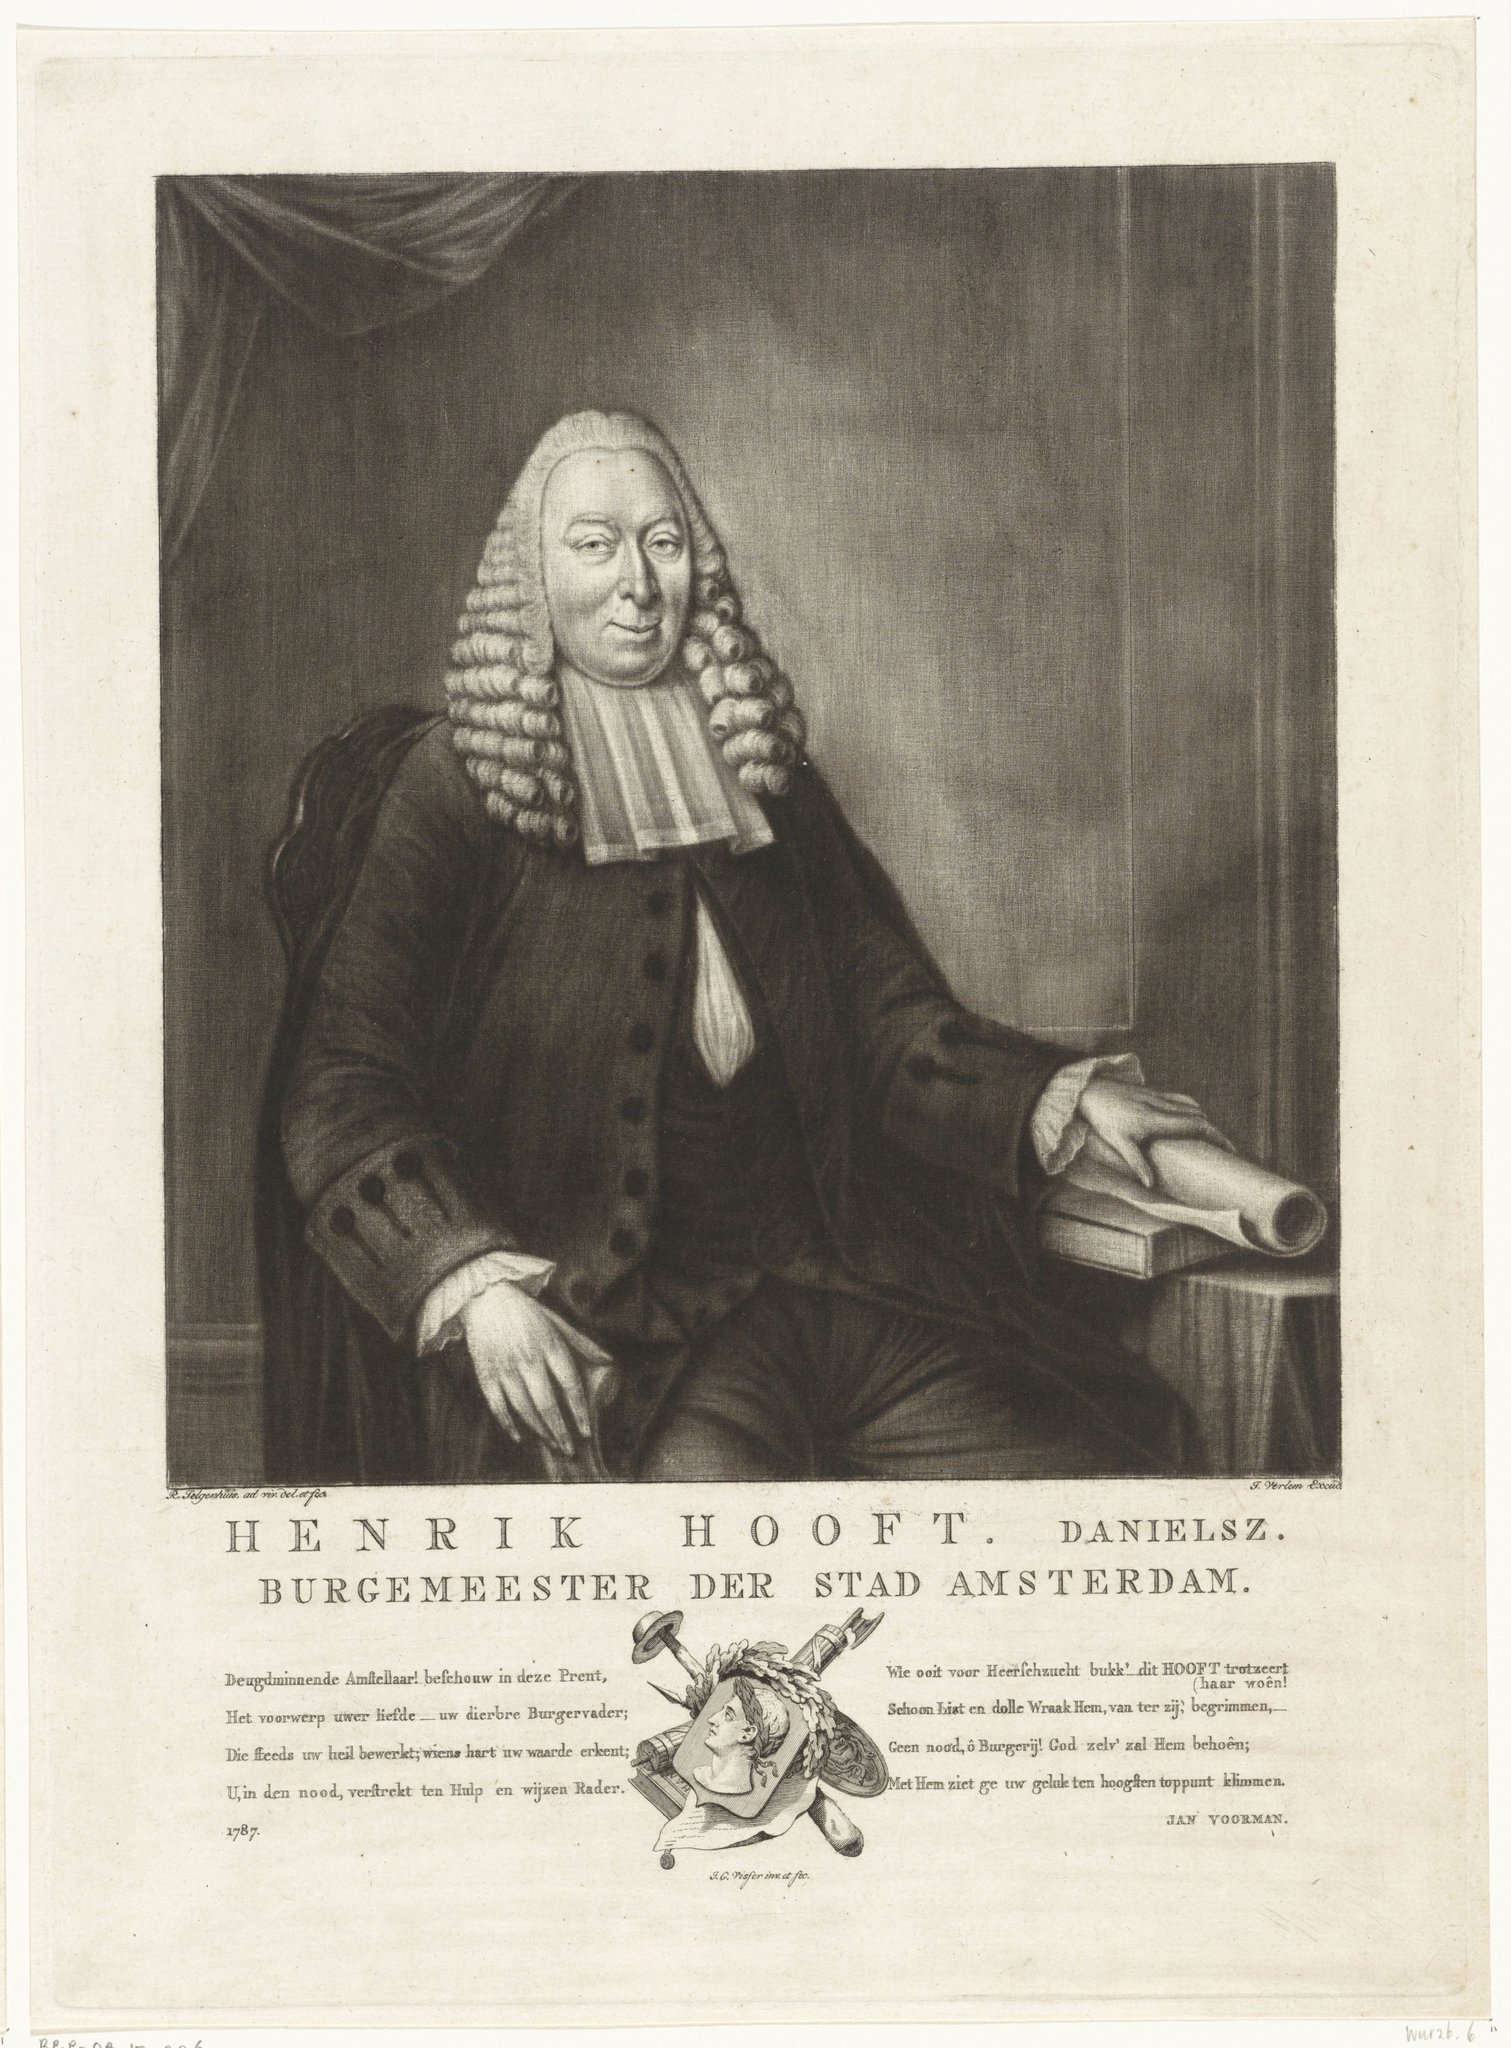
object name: print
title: Portret van Hendrik Danielsz. Hooft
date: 1787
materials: paper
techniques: engraving, etching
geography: amsterdam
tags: amsterdam, mayor, hendrik danielsz. hooft, book, wig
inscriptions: date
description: Hendrik Danielsz. Hooft, burgemeester van Amsterdam zit in een stoel en houdt een rol papier vast. Hij draagt een pruik en een brede bef. In de marge twee kolommen met tekst met daar tussen een met lauwerkrans gekroond wapen waaronder twee fasces, een vrijheidshoed en een schild.